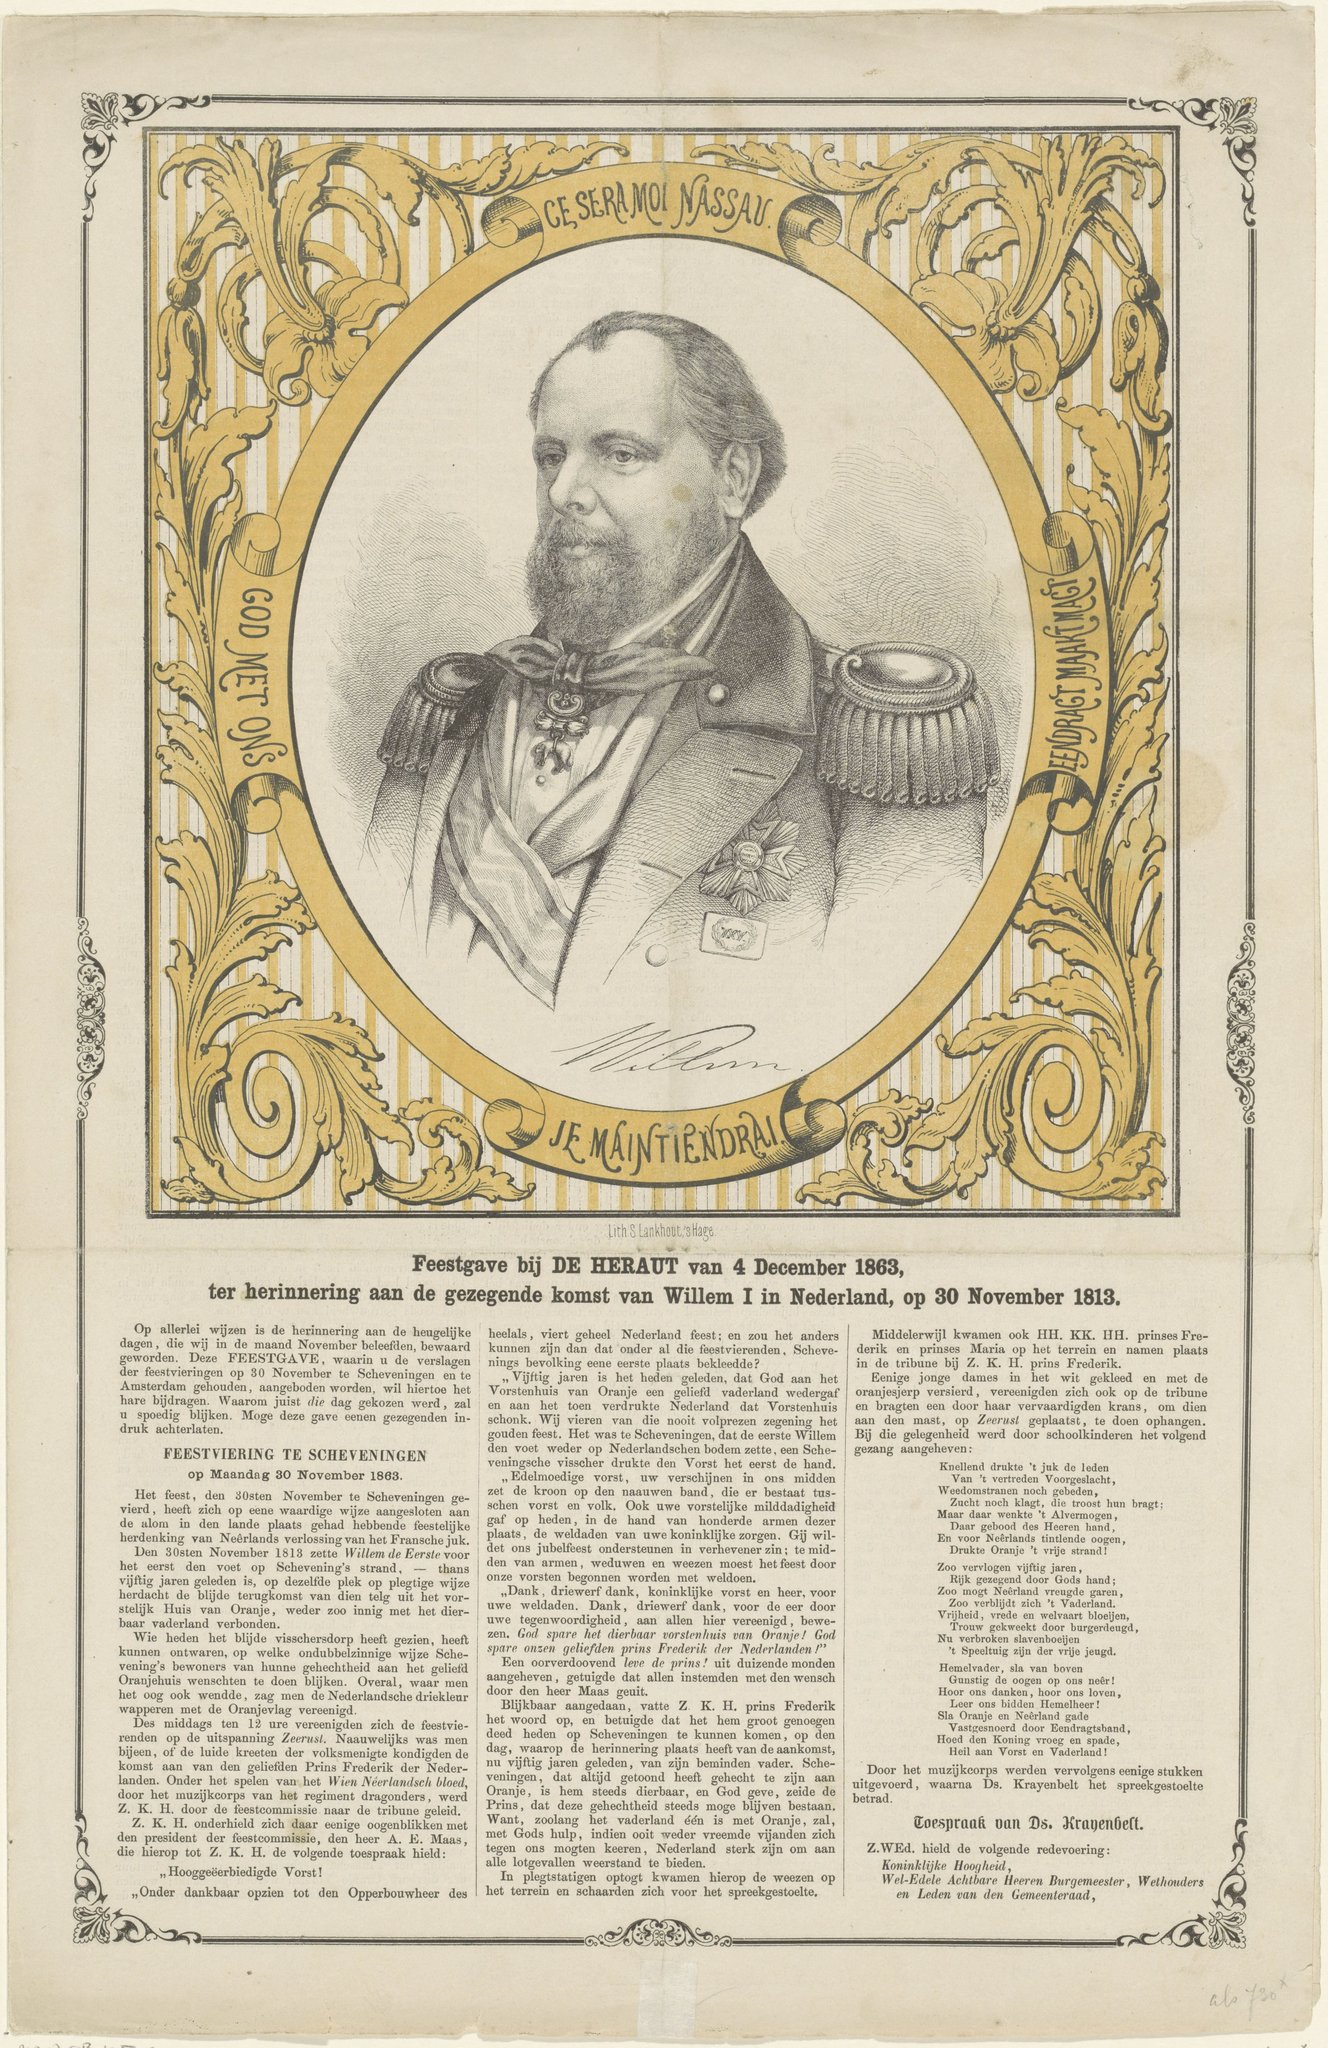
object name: newspaper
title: Feestgave ter herinnering aan de aankomst van Willem I Frederik, koning der Nederlanden, in Nederland op 30 november 1813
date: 1863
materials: paper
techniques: lithograph, letterpress printing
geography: netherlands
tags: the hague, berlin, william i of the netherlands, brussels, willem iii (koning der nederlanden), knighthood order of the golden fleece - insignia of a knighthood order, e.g.: badge, chain (with name of order), landing of william frederick i (1813)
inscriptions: date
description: Feestgave ter herinnering aan de aankomst van Willem I Frederik in Nederland op 30 november 1813. Midden boven een portret van Willem III in een geornamenteerd ovaal met randschrift. Daaronder drie kolommen met Nederlandse tekst in boekdruk. Geheel in een geornamenteerde rechthoek.